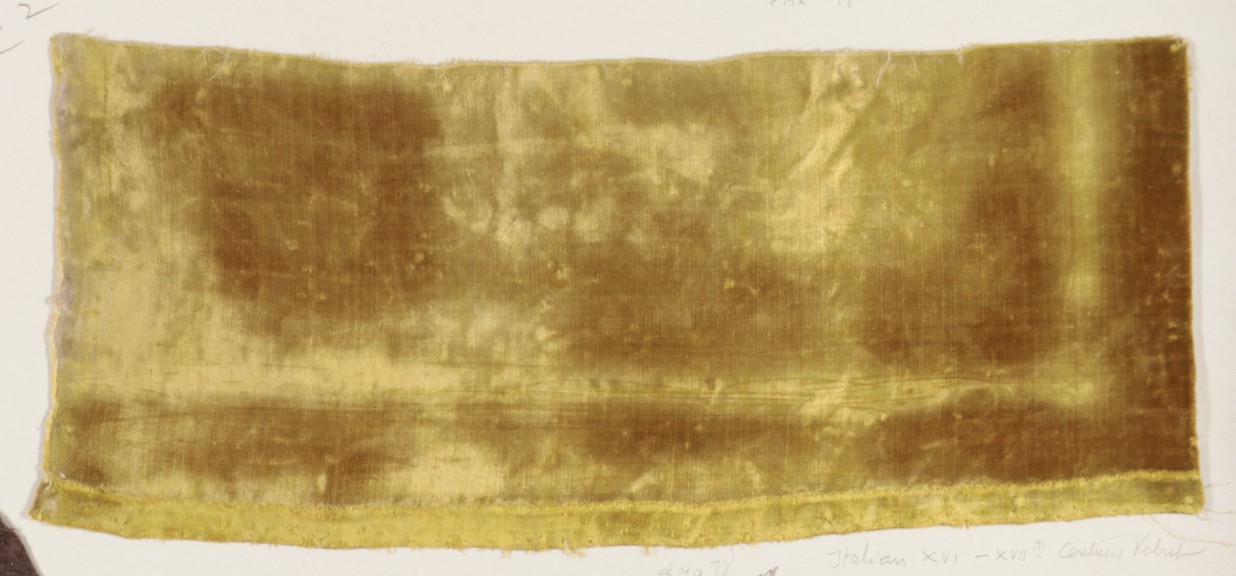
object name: fragment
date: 1501-1700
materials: silk